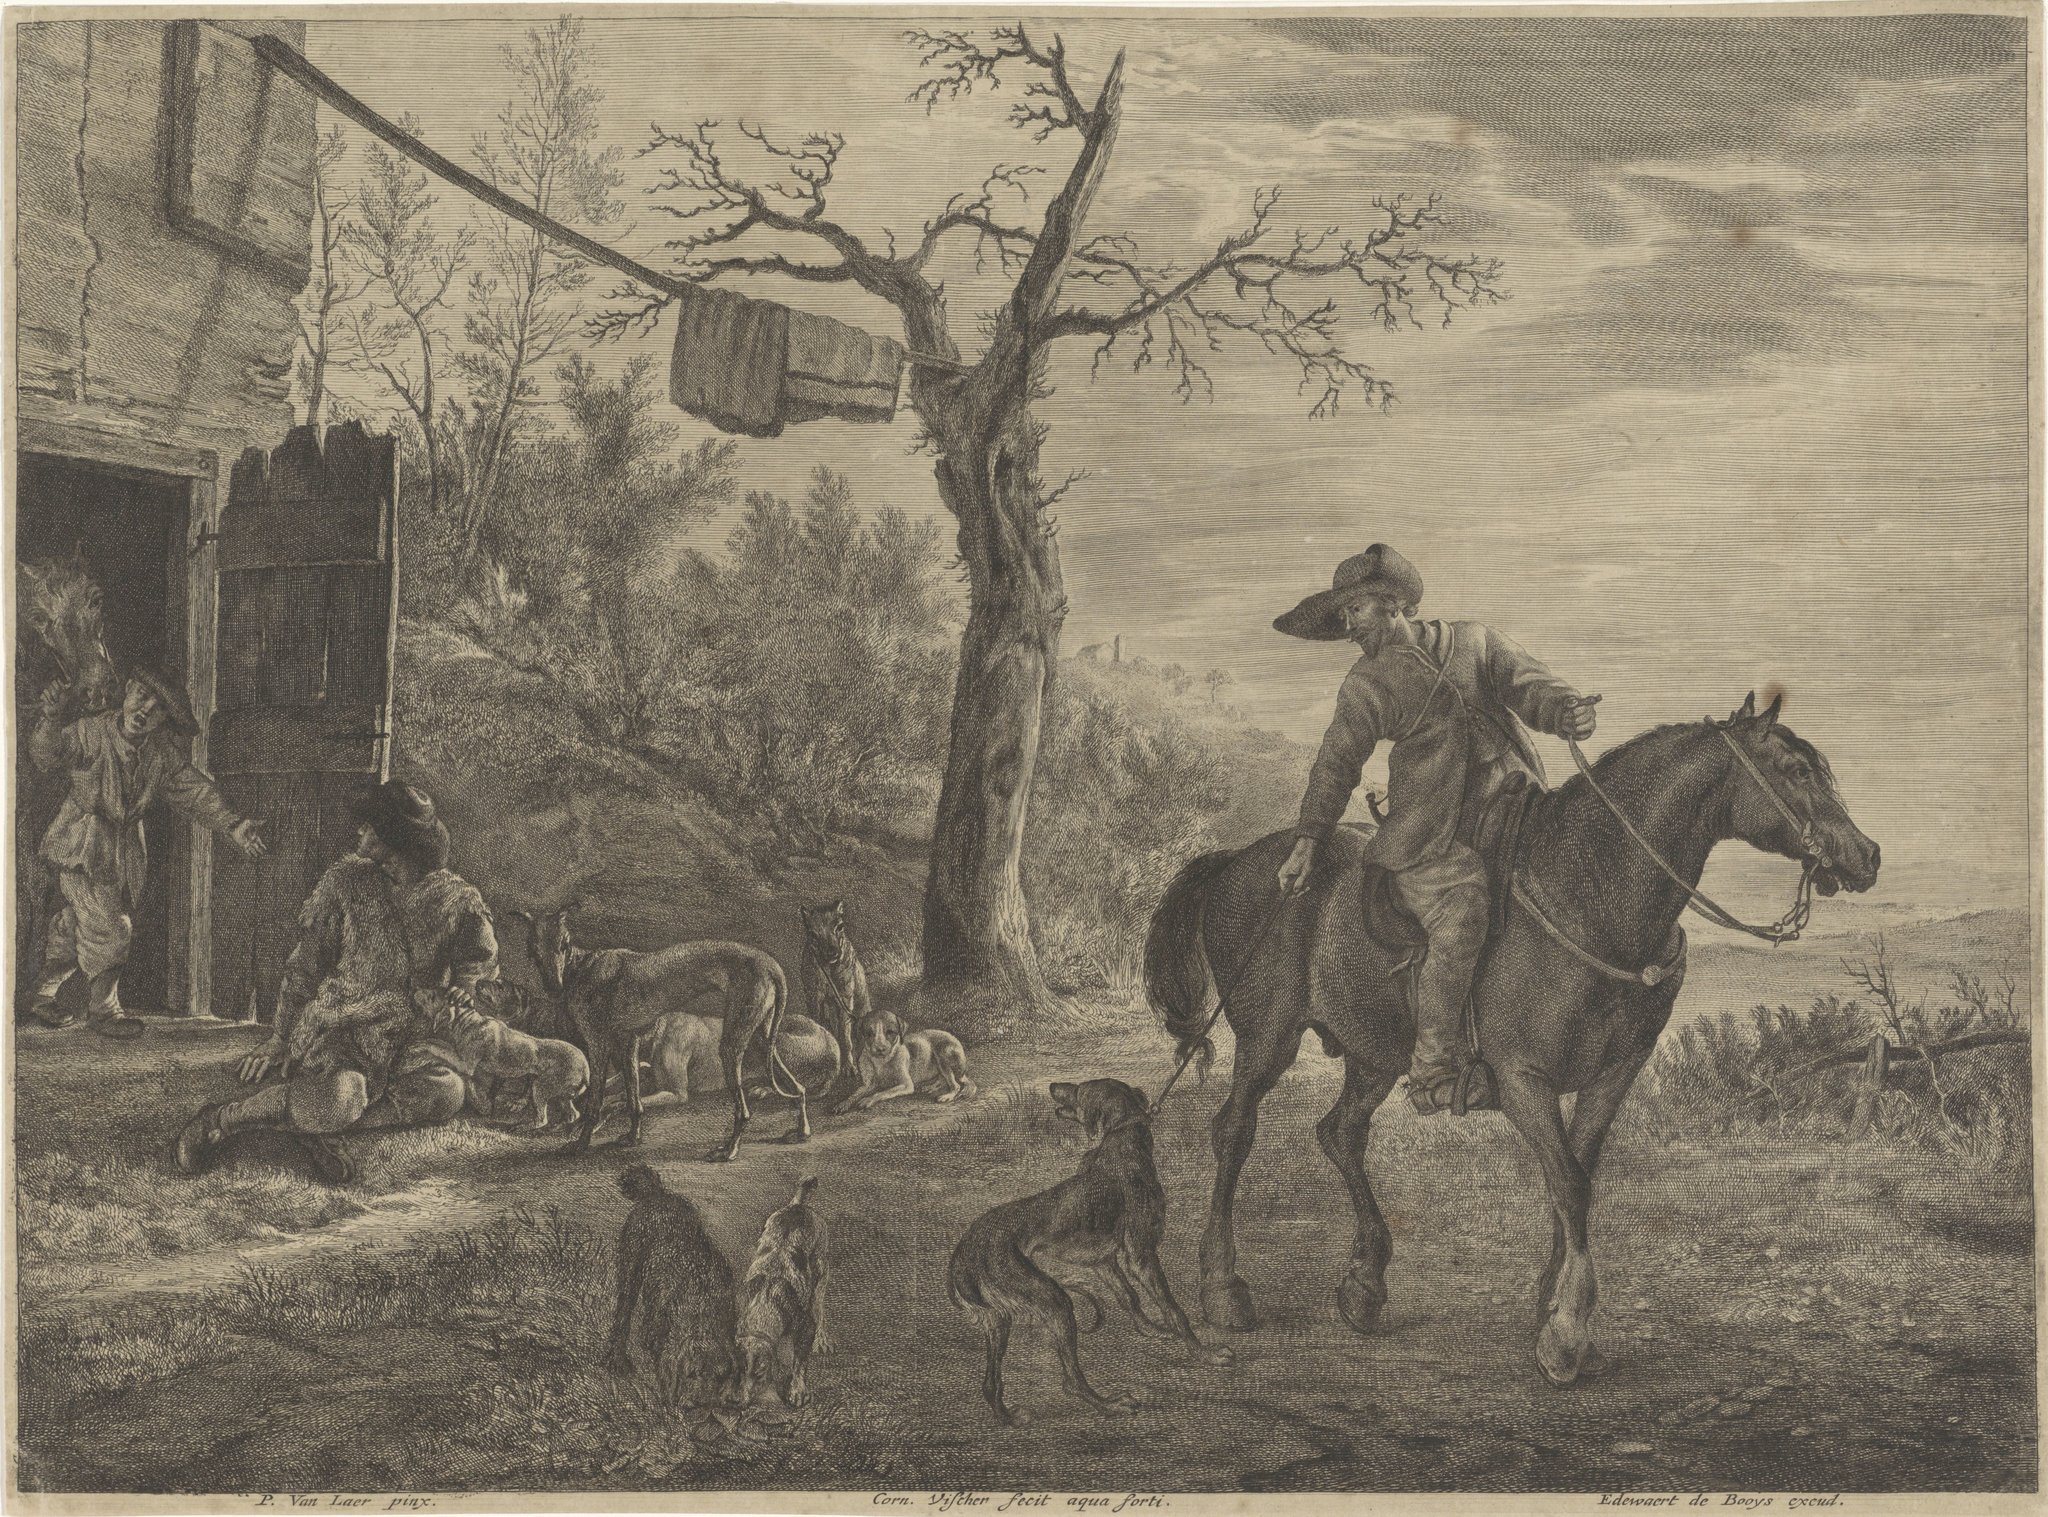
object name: print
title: Jagers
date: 1638-1658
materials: paper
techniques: etching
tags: riding a horse, ass, or mule; rider, horseman, landscapes, hunting dogs, hunter, stall, stable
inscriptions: collector's mark: Lugt 240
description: Een jager staat op het punt om te paard te vertrekken voor de jacht. Zijn aangelijnde jachthond stribbelt tegen. Een dienstknecht haalt een tweede paard van stal, mogelijk voor de jager die tussen zijn honden voor de stal zit te wachten.